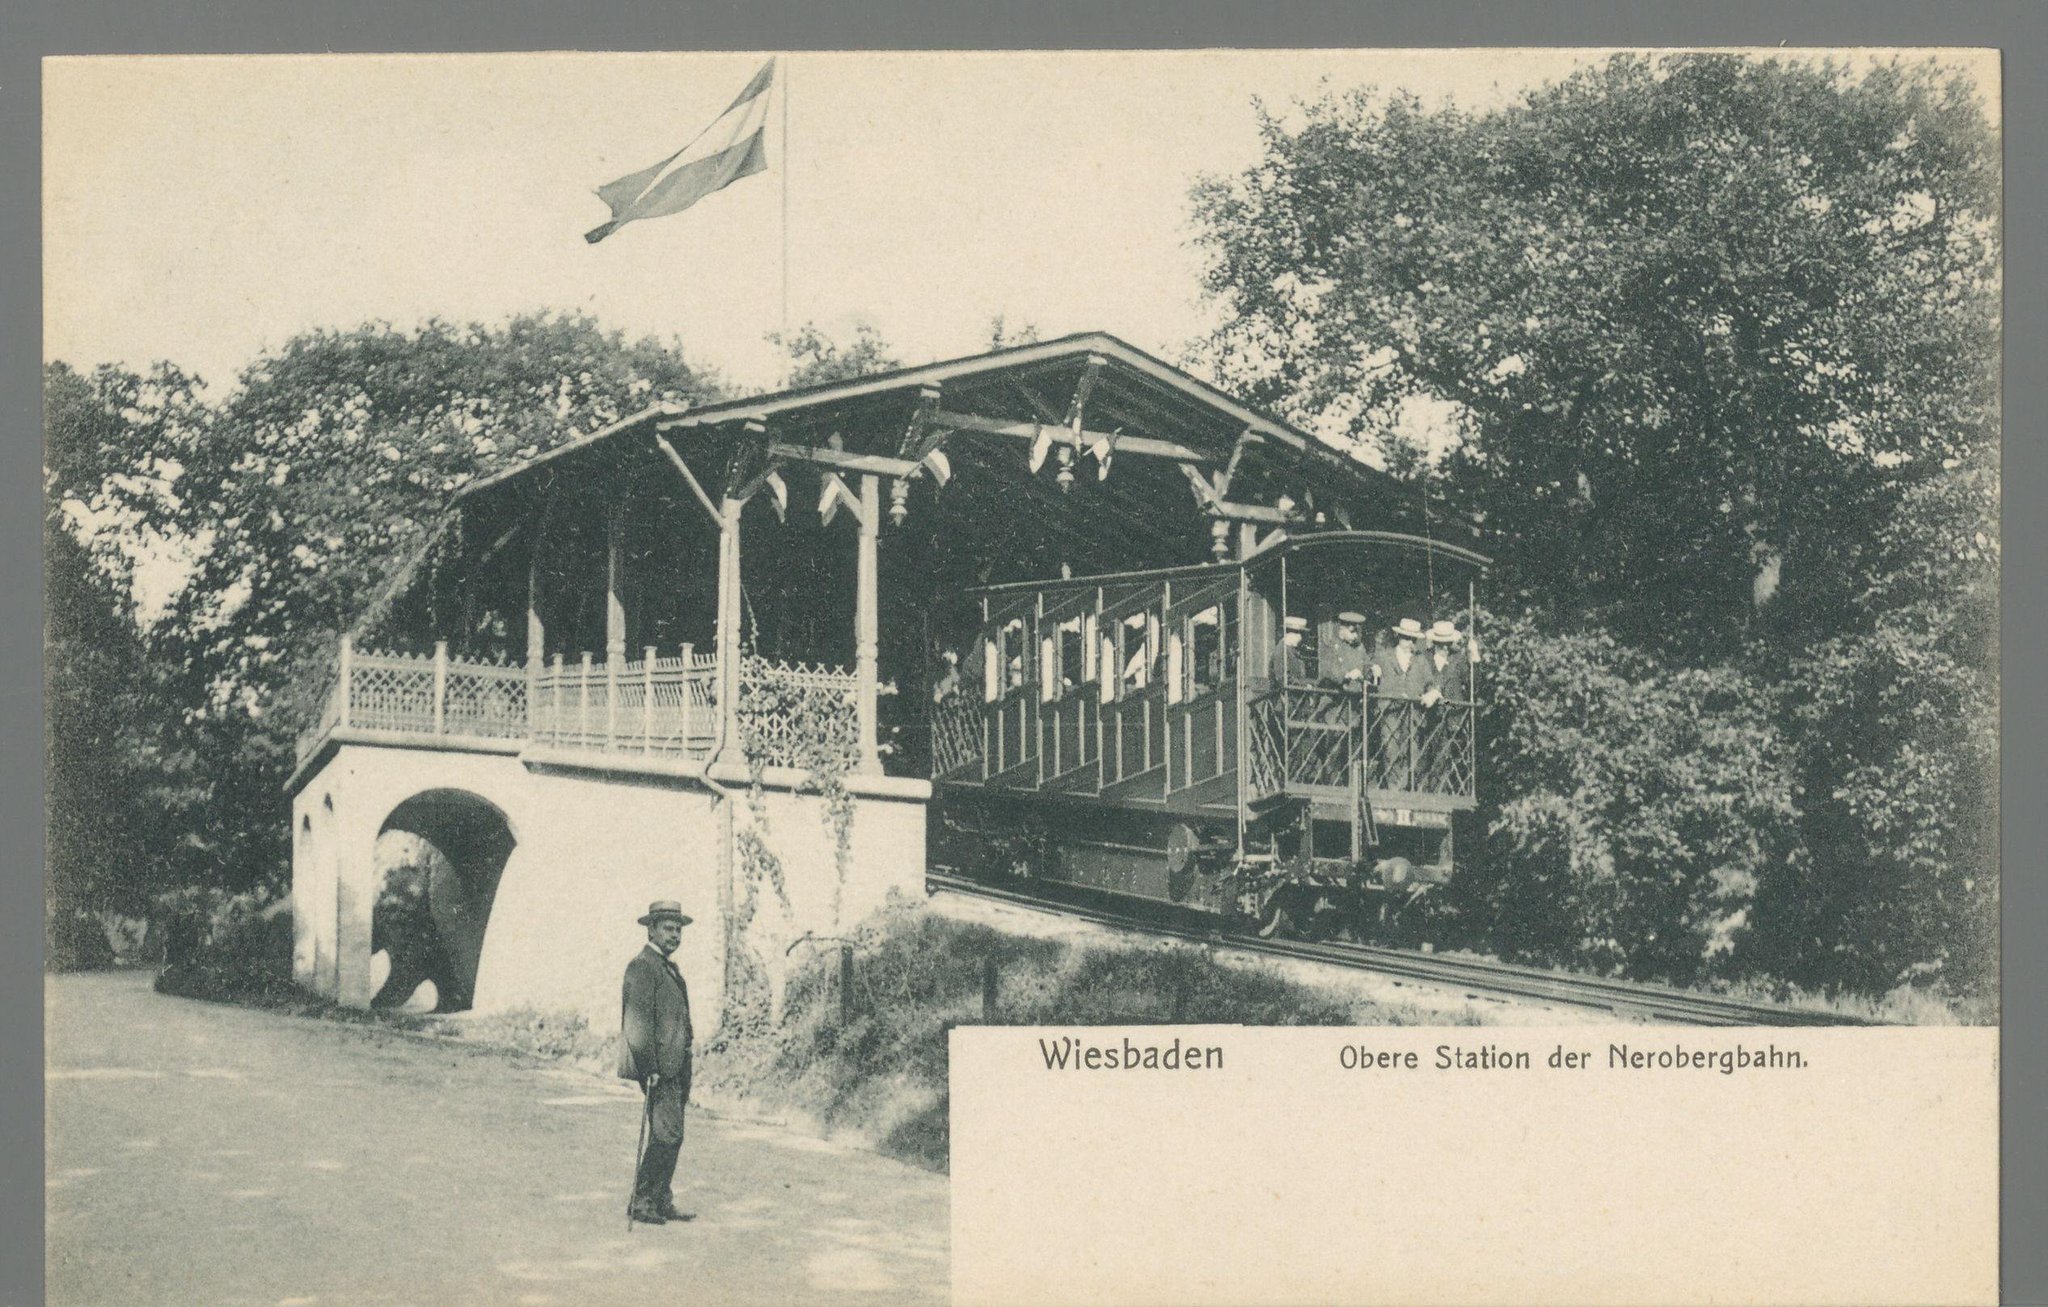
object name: photomechanical print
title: Wiesbaden. Obere Station der Nerobergbahn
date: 1905-1930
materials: cardboard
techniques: photograph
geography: wiesbaden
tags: rack railway, station; shelter (railway, tramway)